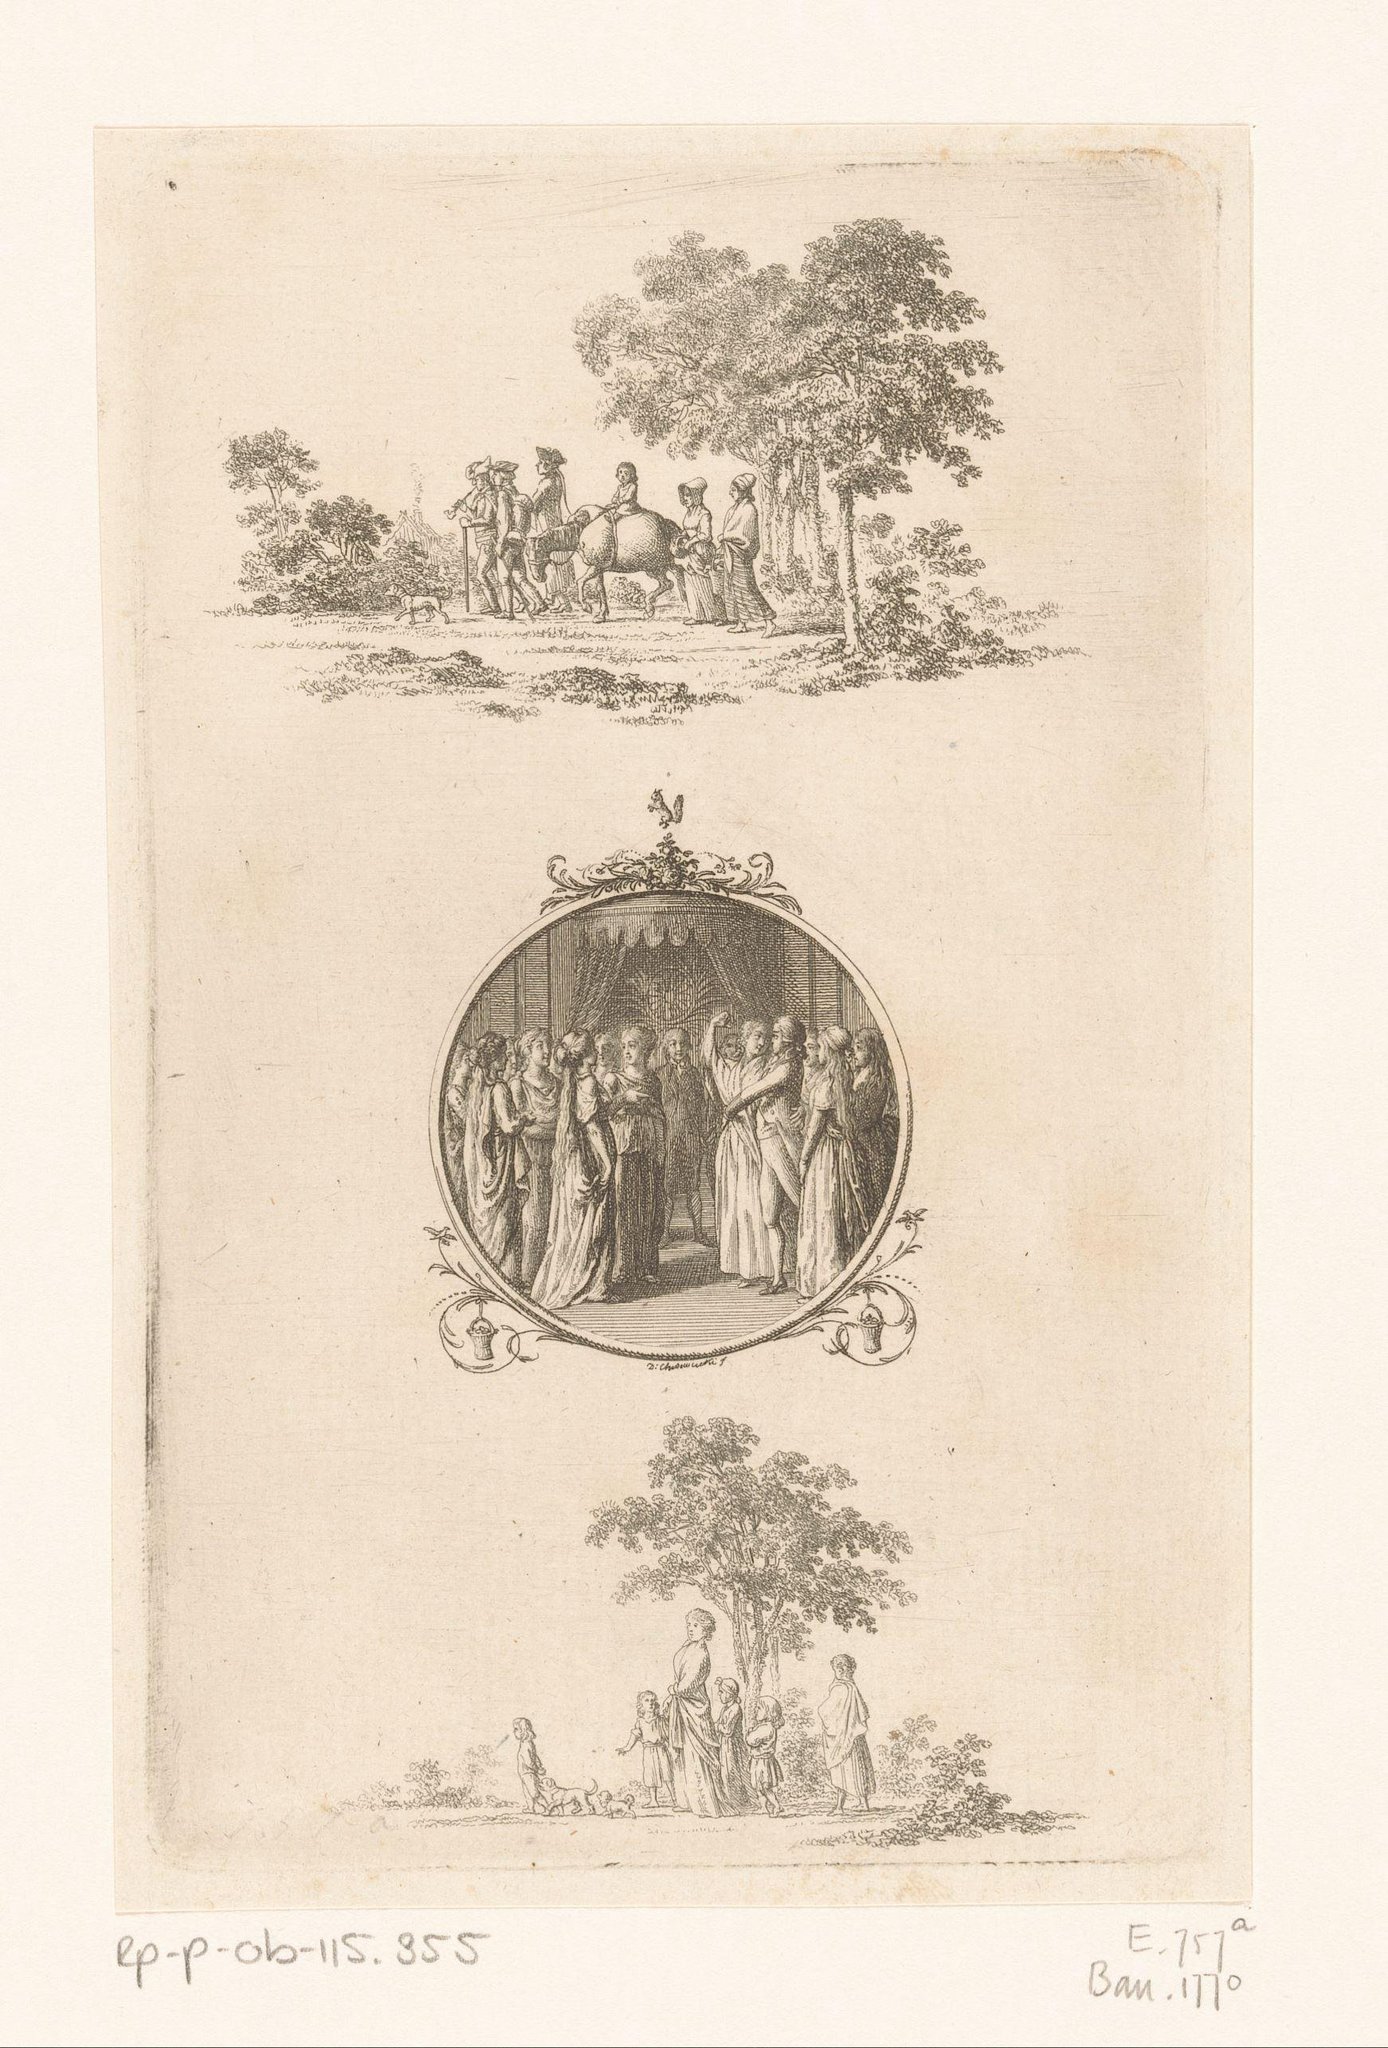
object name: print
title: Koningspaar aan het hof van Titetane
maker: daniel nikolaus chodowiecki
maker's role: draughtsman, print maker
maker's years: 1726-1801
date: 1794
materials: paper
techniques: etching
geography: berlin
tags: landscapes, canopy, baldachin, family of a ruler, and court, ornament ~ medallion, 'en route', traveller under way, rodents: squirrel, court-room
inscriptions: collector's mark: Lugt 2228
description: Latere staat gebruikt voor: Honig, Gustav. Grigri, eine Arabeske, nach einem französischen Meister (...). Weimar: Hofmannischen Buchhandlung, 1795.